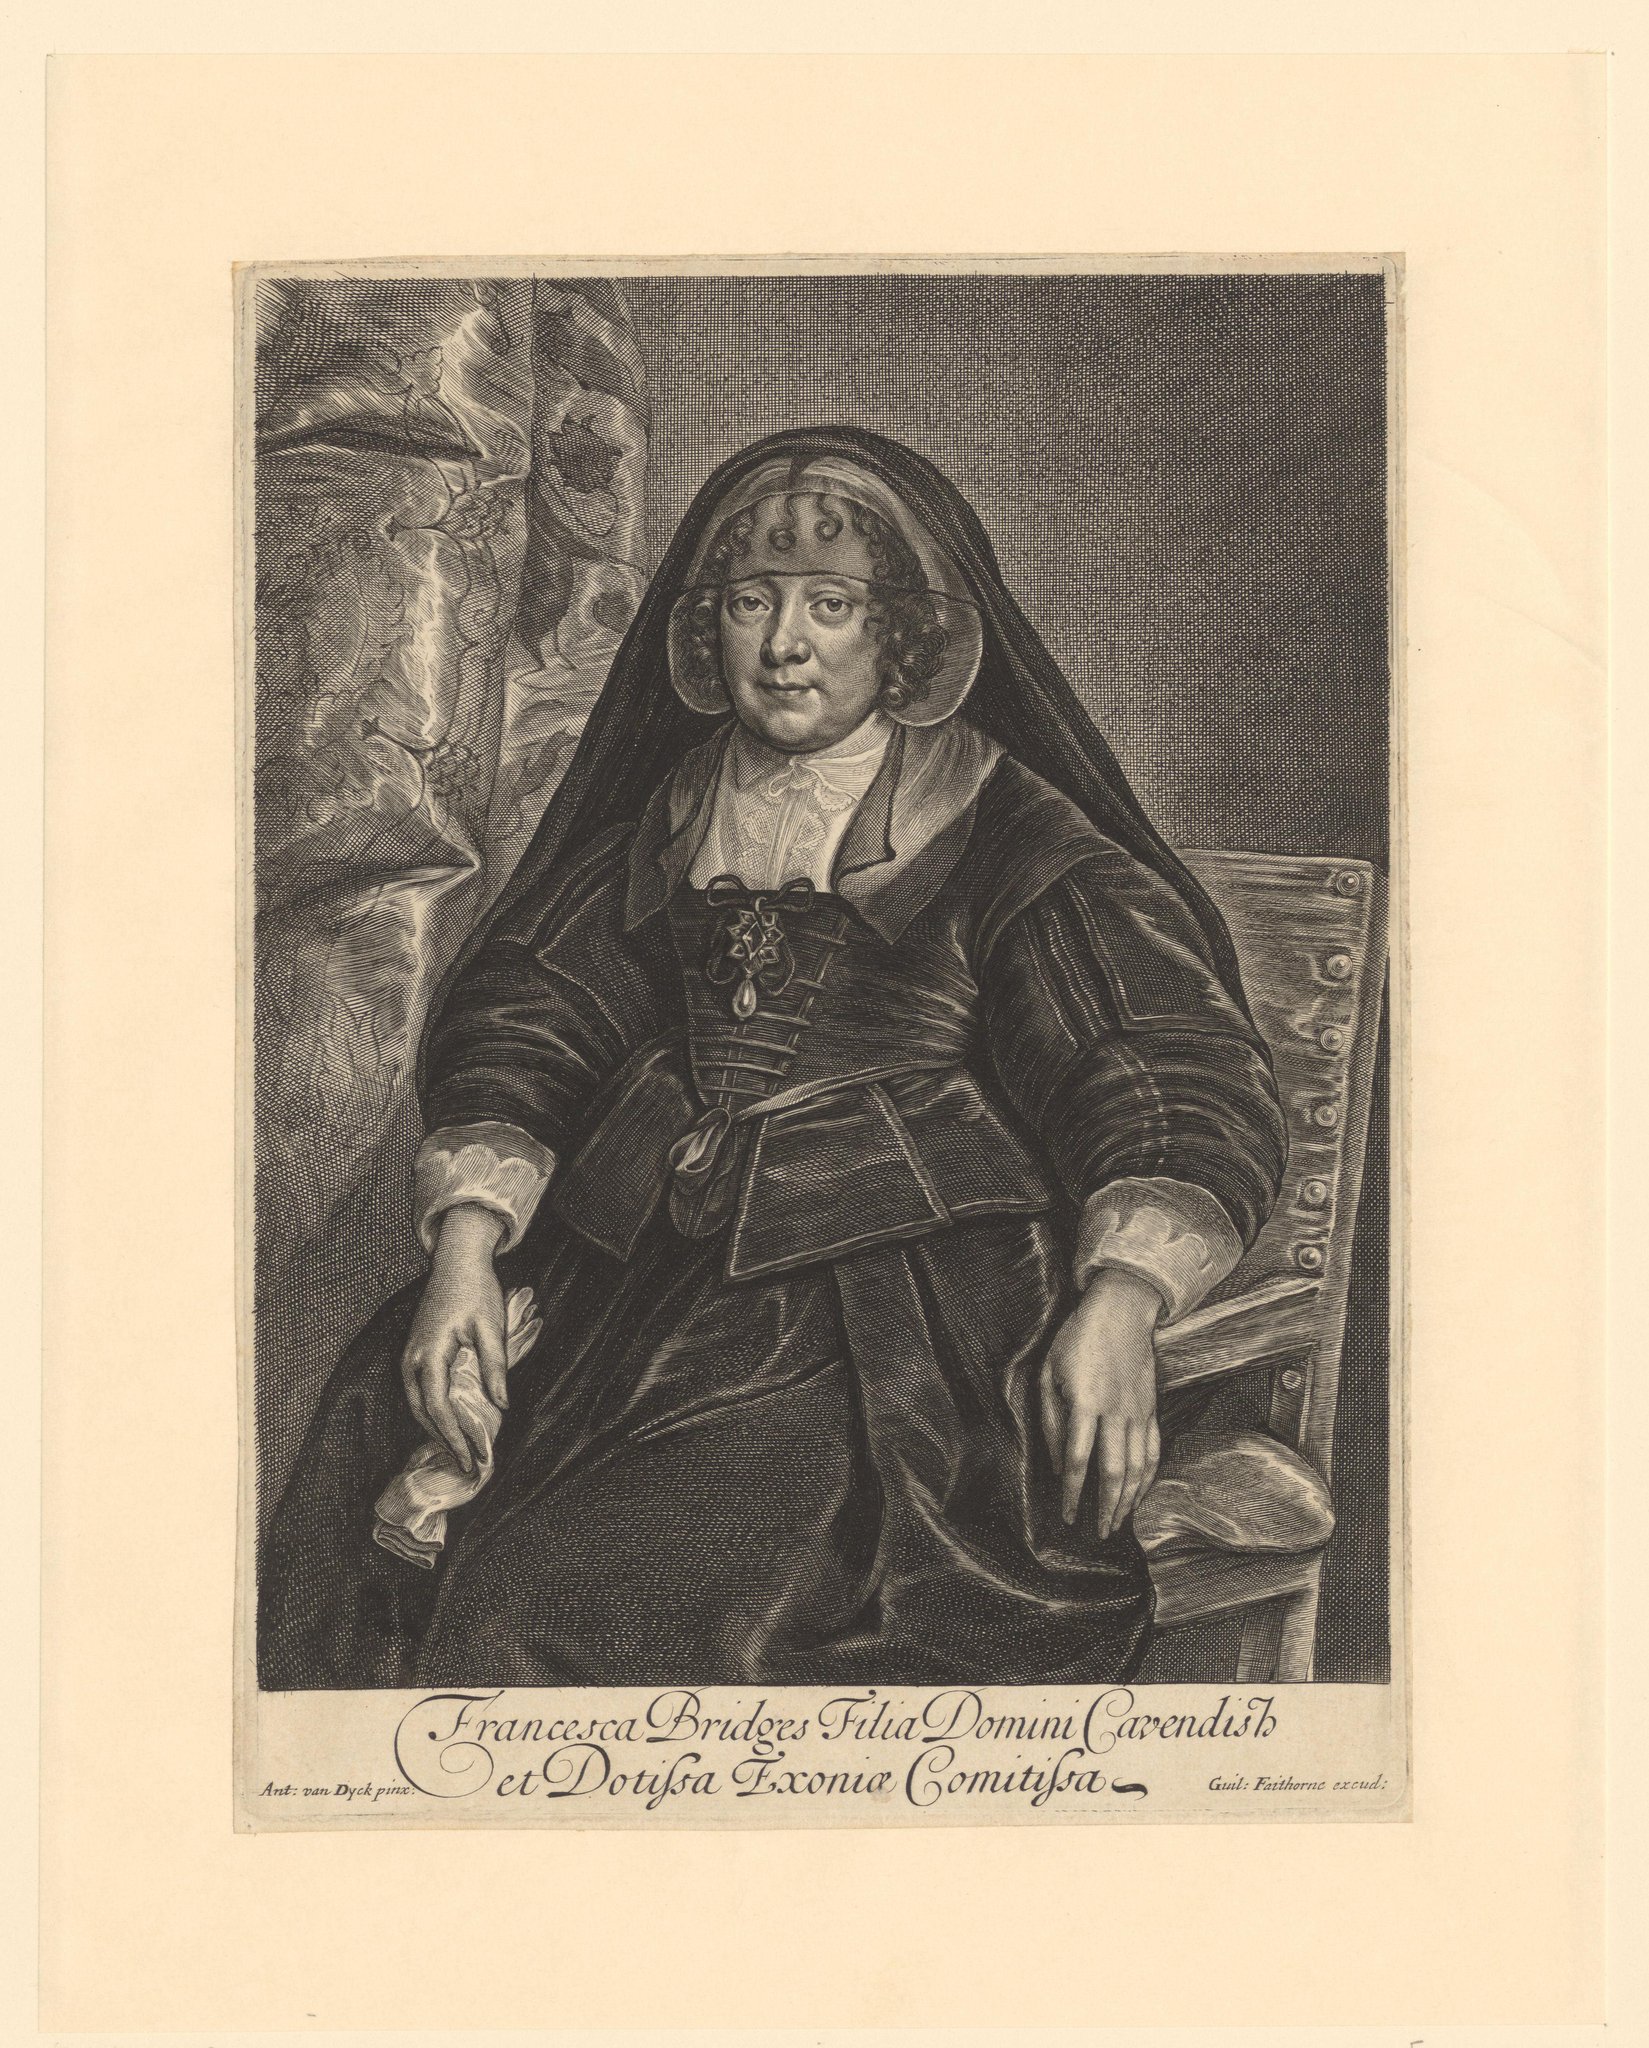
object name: print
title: Francesca Bridges Filia Domini Cavendish (...)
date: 1650-1663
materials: paper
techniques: engraving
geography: london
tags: historical persons - bb - woman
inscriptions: collector's mark: Lugt 2760, collector's mark: Lugt 2228